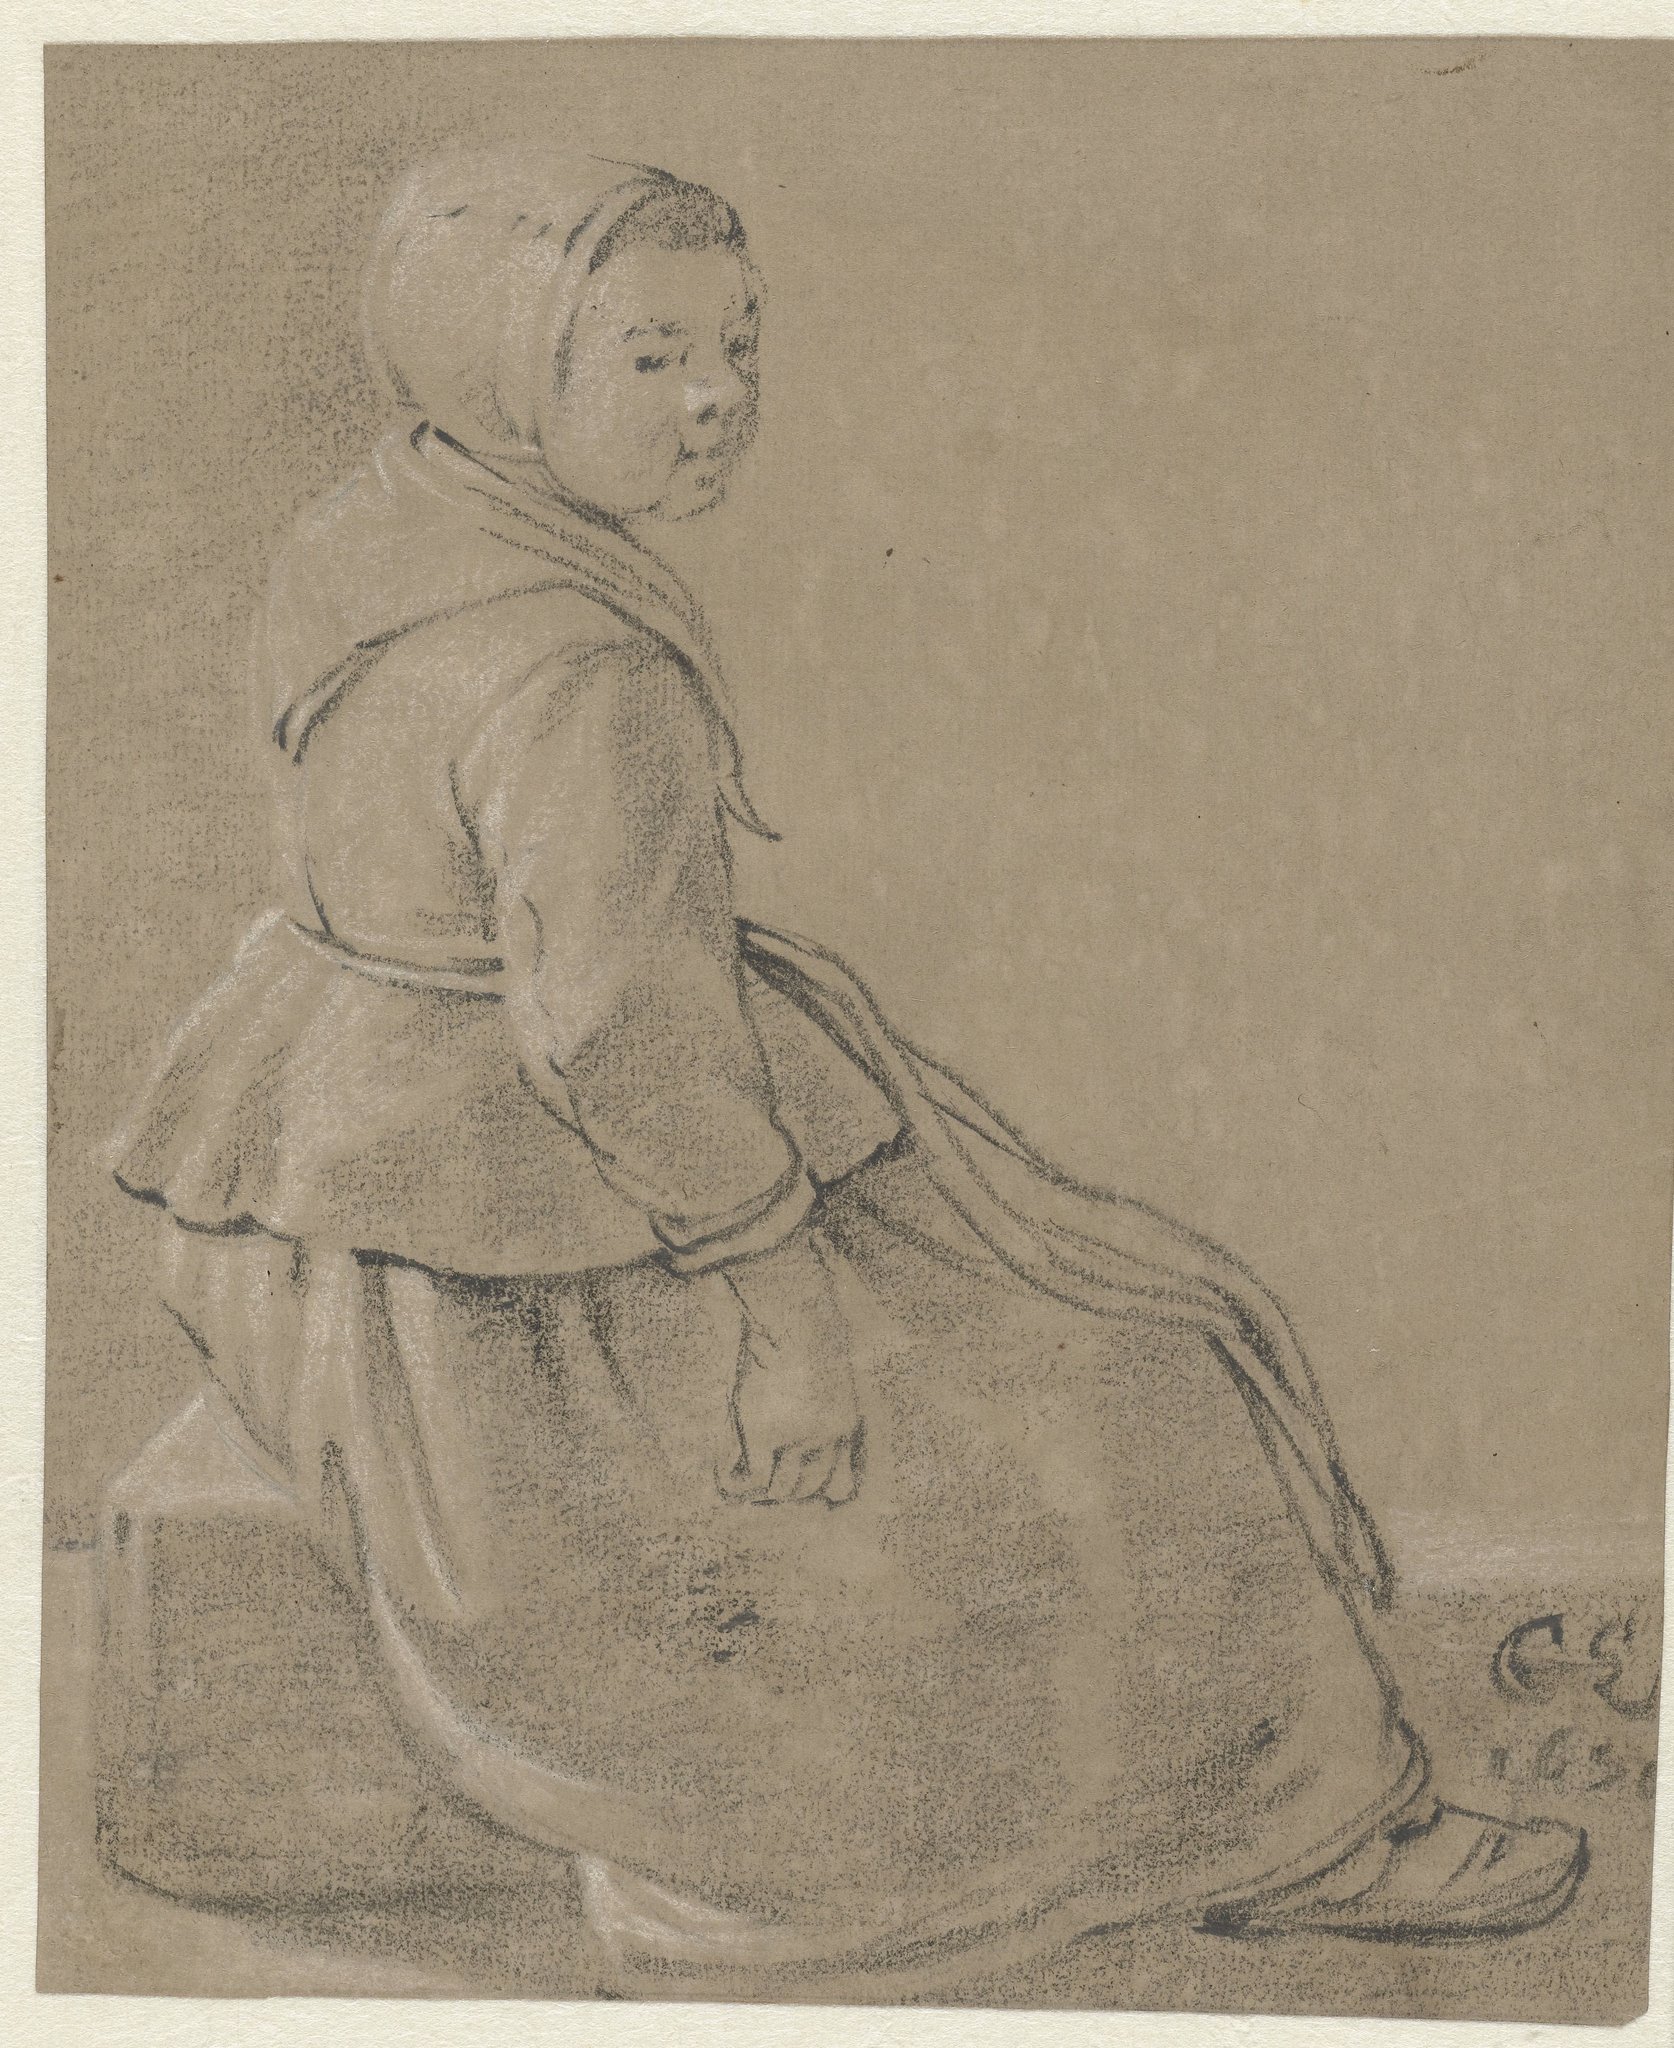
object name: drawing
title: Seated Girl, in Profile to the Right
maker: cornelis saftleven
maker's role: draughtsman, painter, print maker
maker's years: 1607-1681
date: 1656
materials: chalk, graphite, paper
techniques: drawing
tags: sitting figure - aa - female human figure, girl (child between toddler and youth)